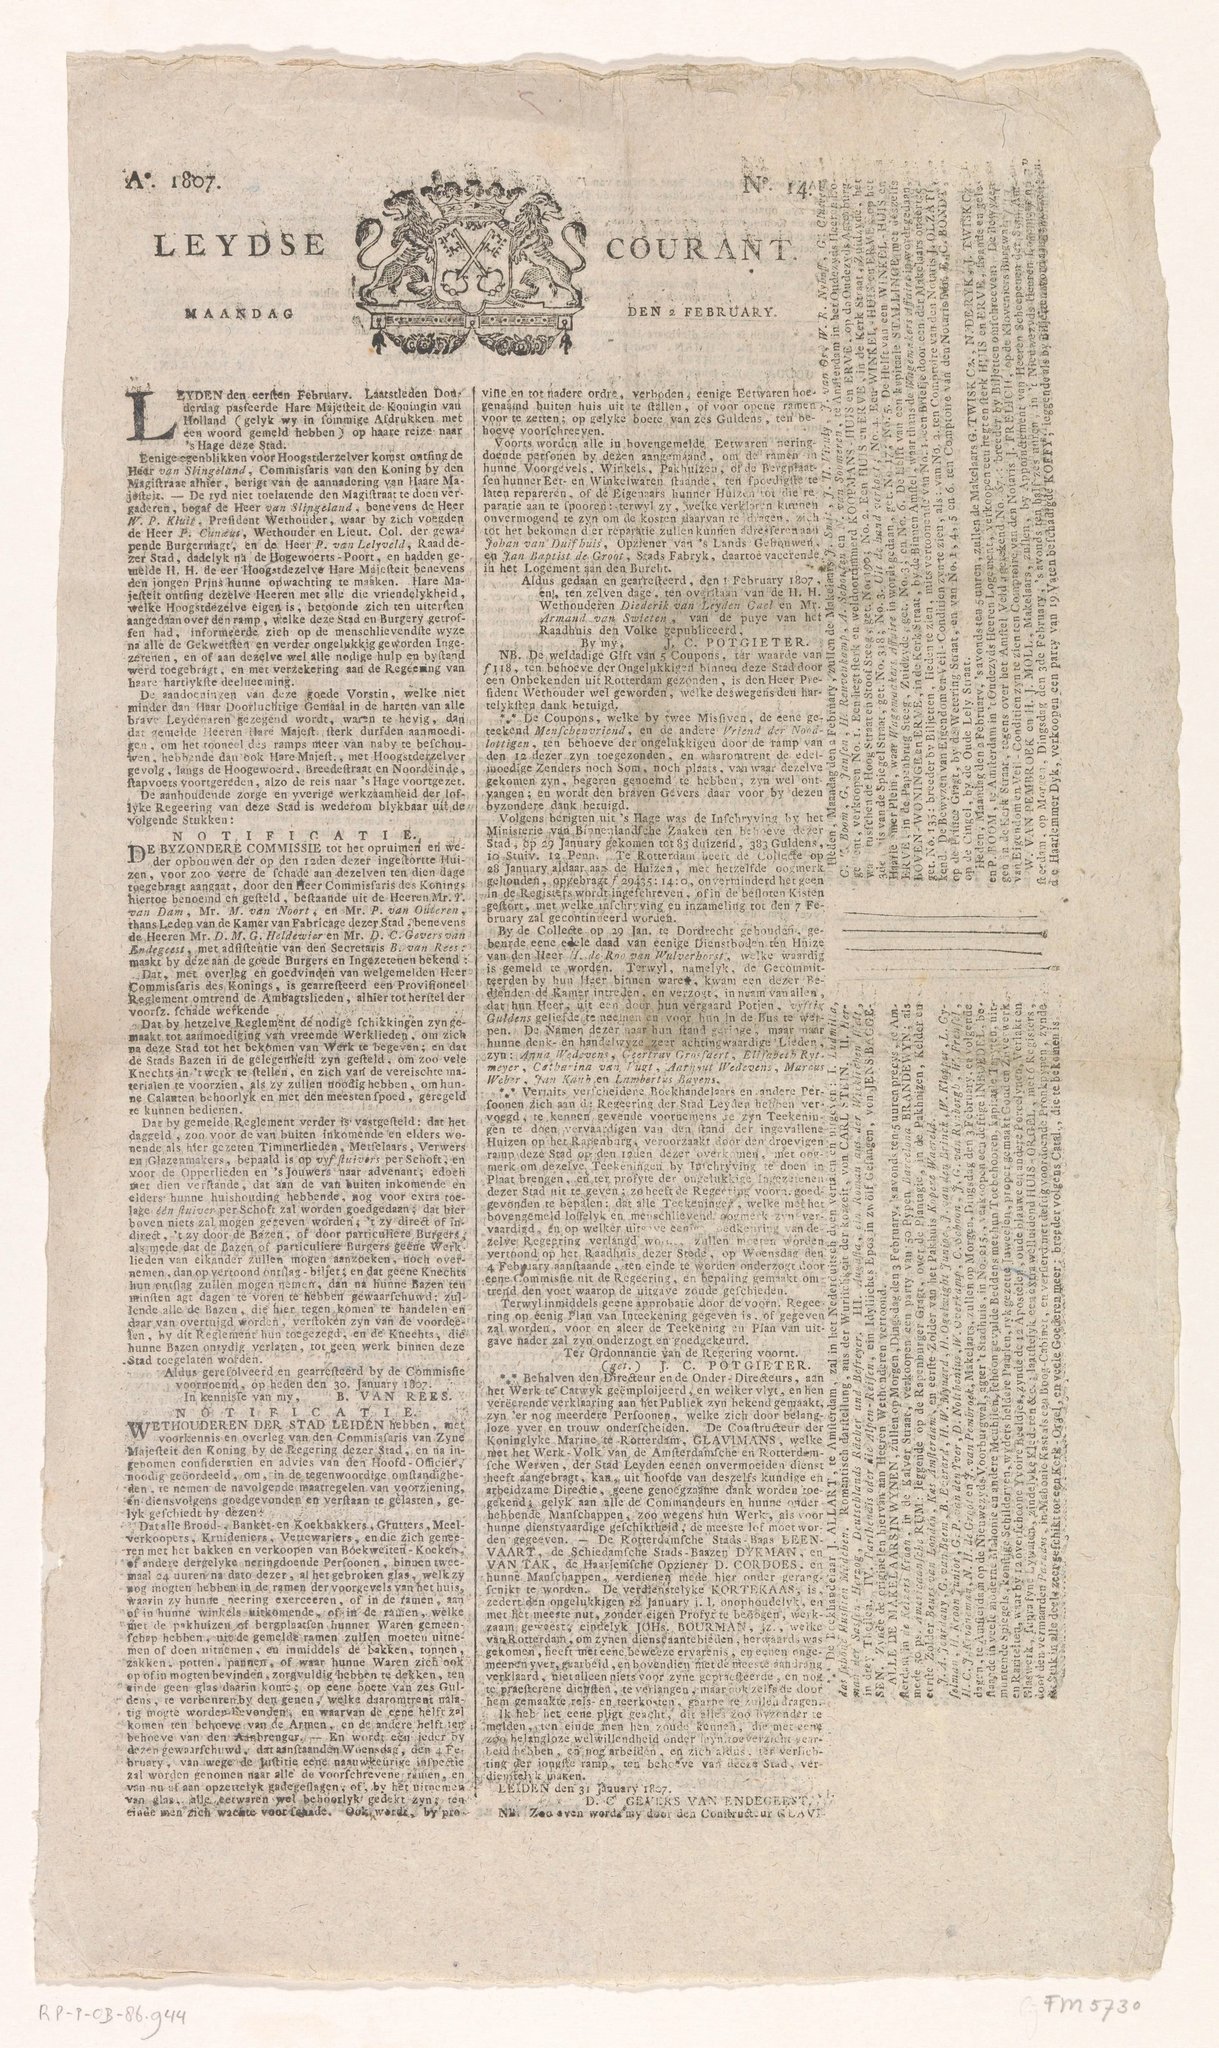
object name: newspaper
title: Leydse Courant van 2 februari 1807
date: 1807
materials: paper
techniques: letterpress printing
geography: leiden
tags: leiden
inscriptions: collector's mark: Lugt 2228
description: De Leydse Courant van 2 februari 1807. Blad bedrukt op beide zijden, bovenaan het stadswapen van Leiden, met nieuws over de buskruitramp in Leiden op 12 januari 1807.